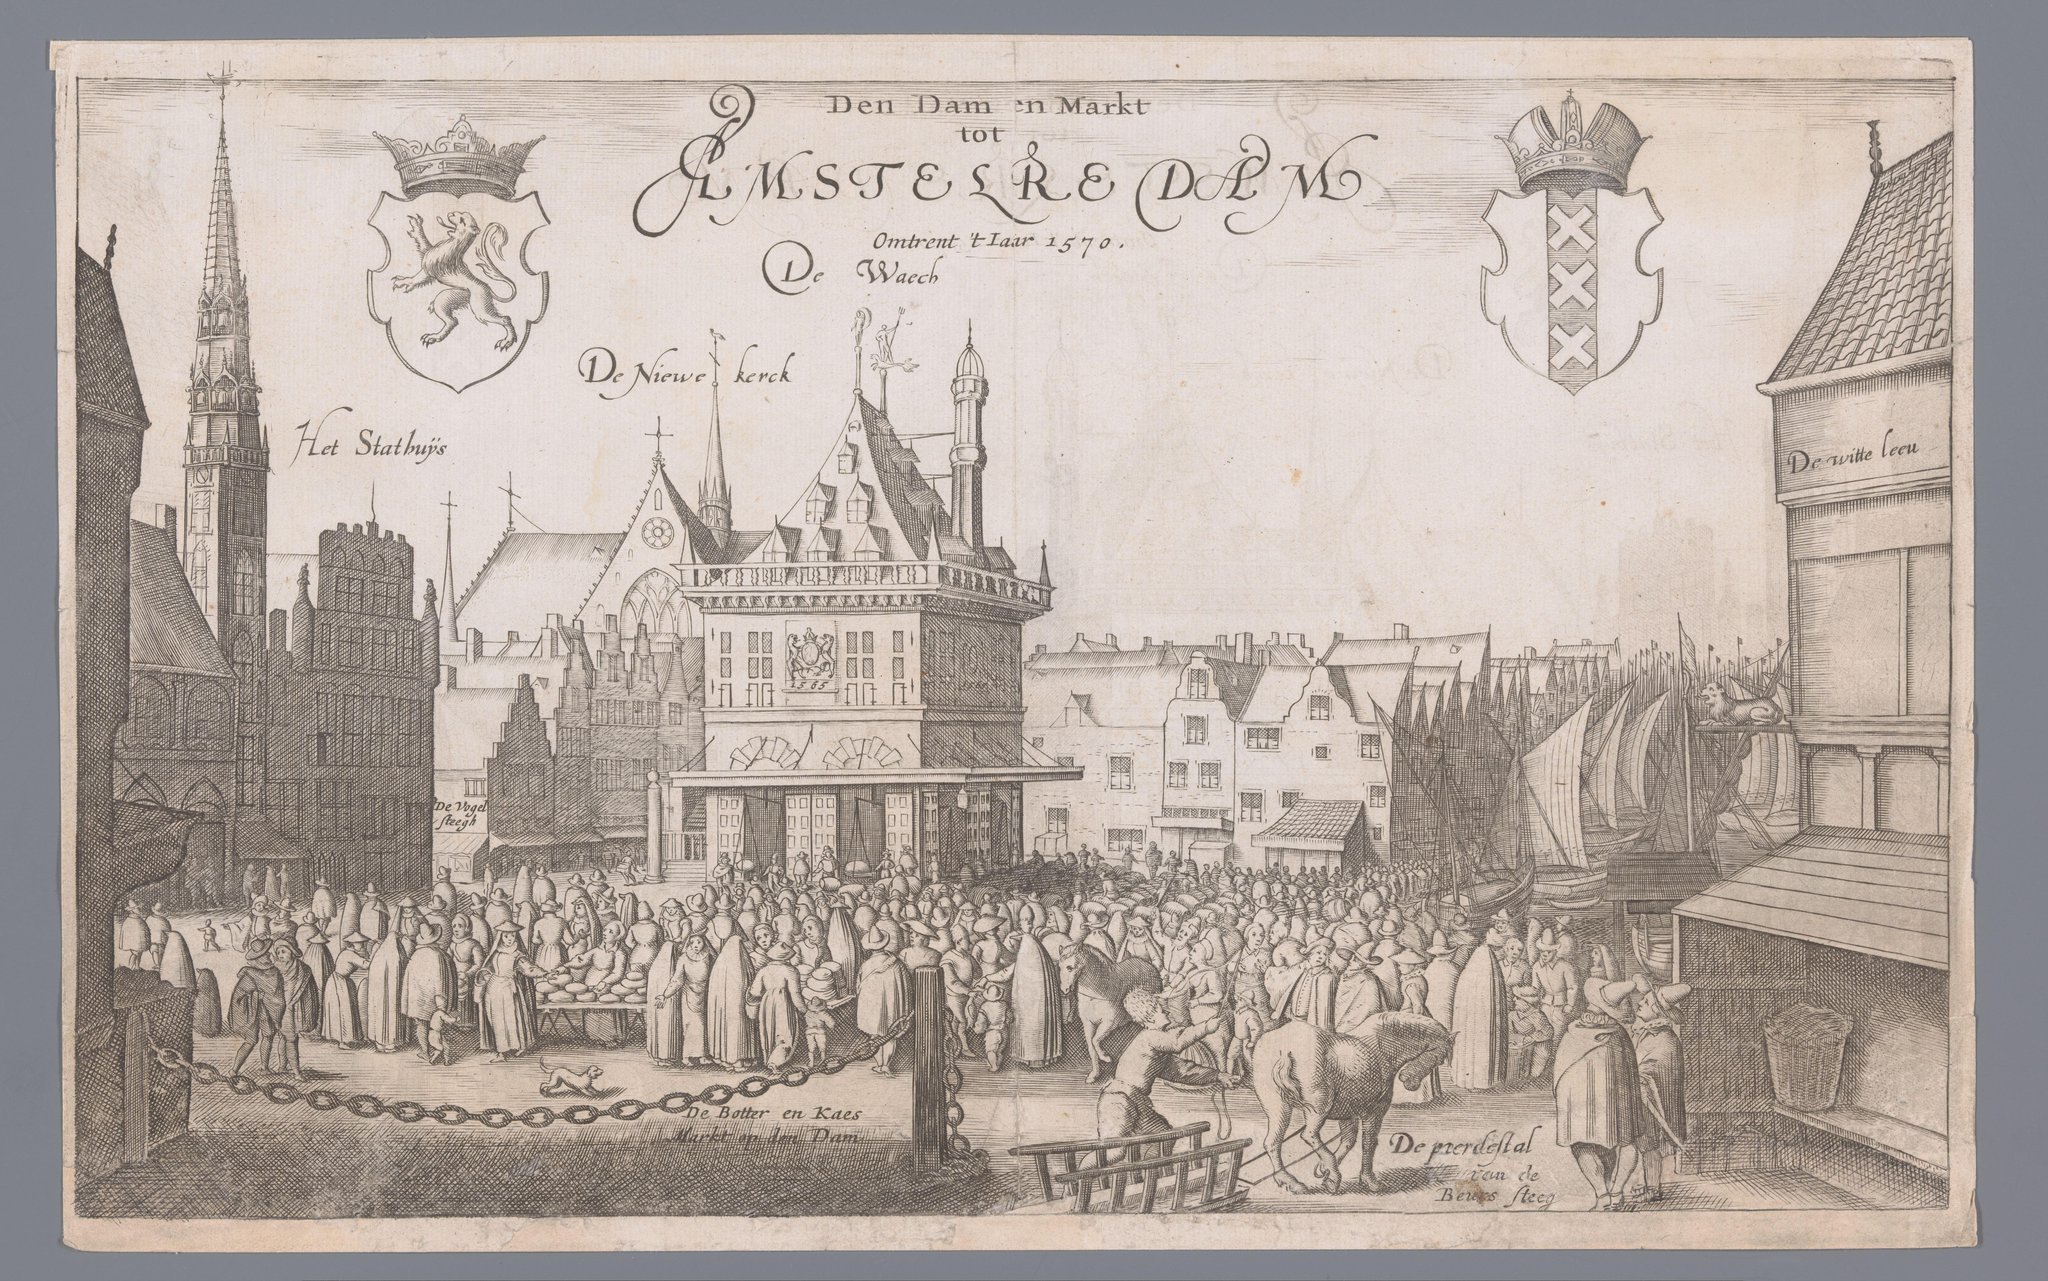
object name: book illustration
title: Noordzijde van de Dam met de weekmarkt voor boter, kaas, eieren en spek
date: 1665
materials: paper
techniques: engraving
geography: amsterdam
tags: church (exterior), townhall, market, weigh-house, village square, place (+ city(-scape) with figures, staffage)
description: Afbeelding van de Dam gezien vanuit de Beurssteeg. Links het Stadhuis en op de achtergrond de Nieuwe Kerk. Op de voorgrond de kaas- en botermarkt met daarachter de Waag. Rechts op de voorgrond de herberg de Witte Leeuw. Linksboven het wapen van Holland, in het midden de titel, en rechtsboven het wapen van Amsterdam.